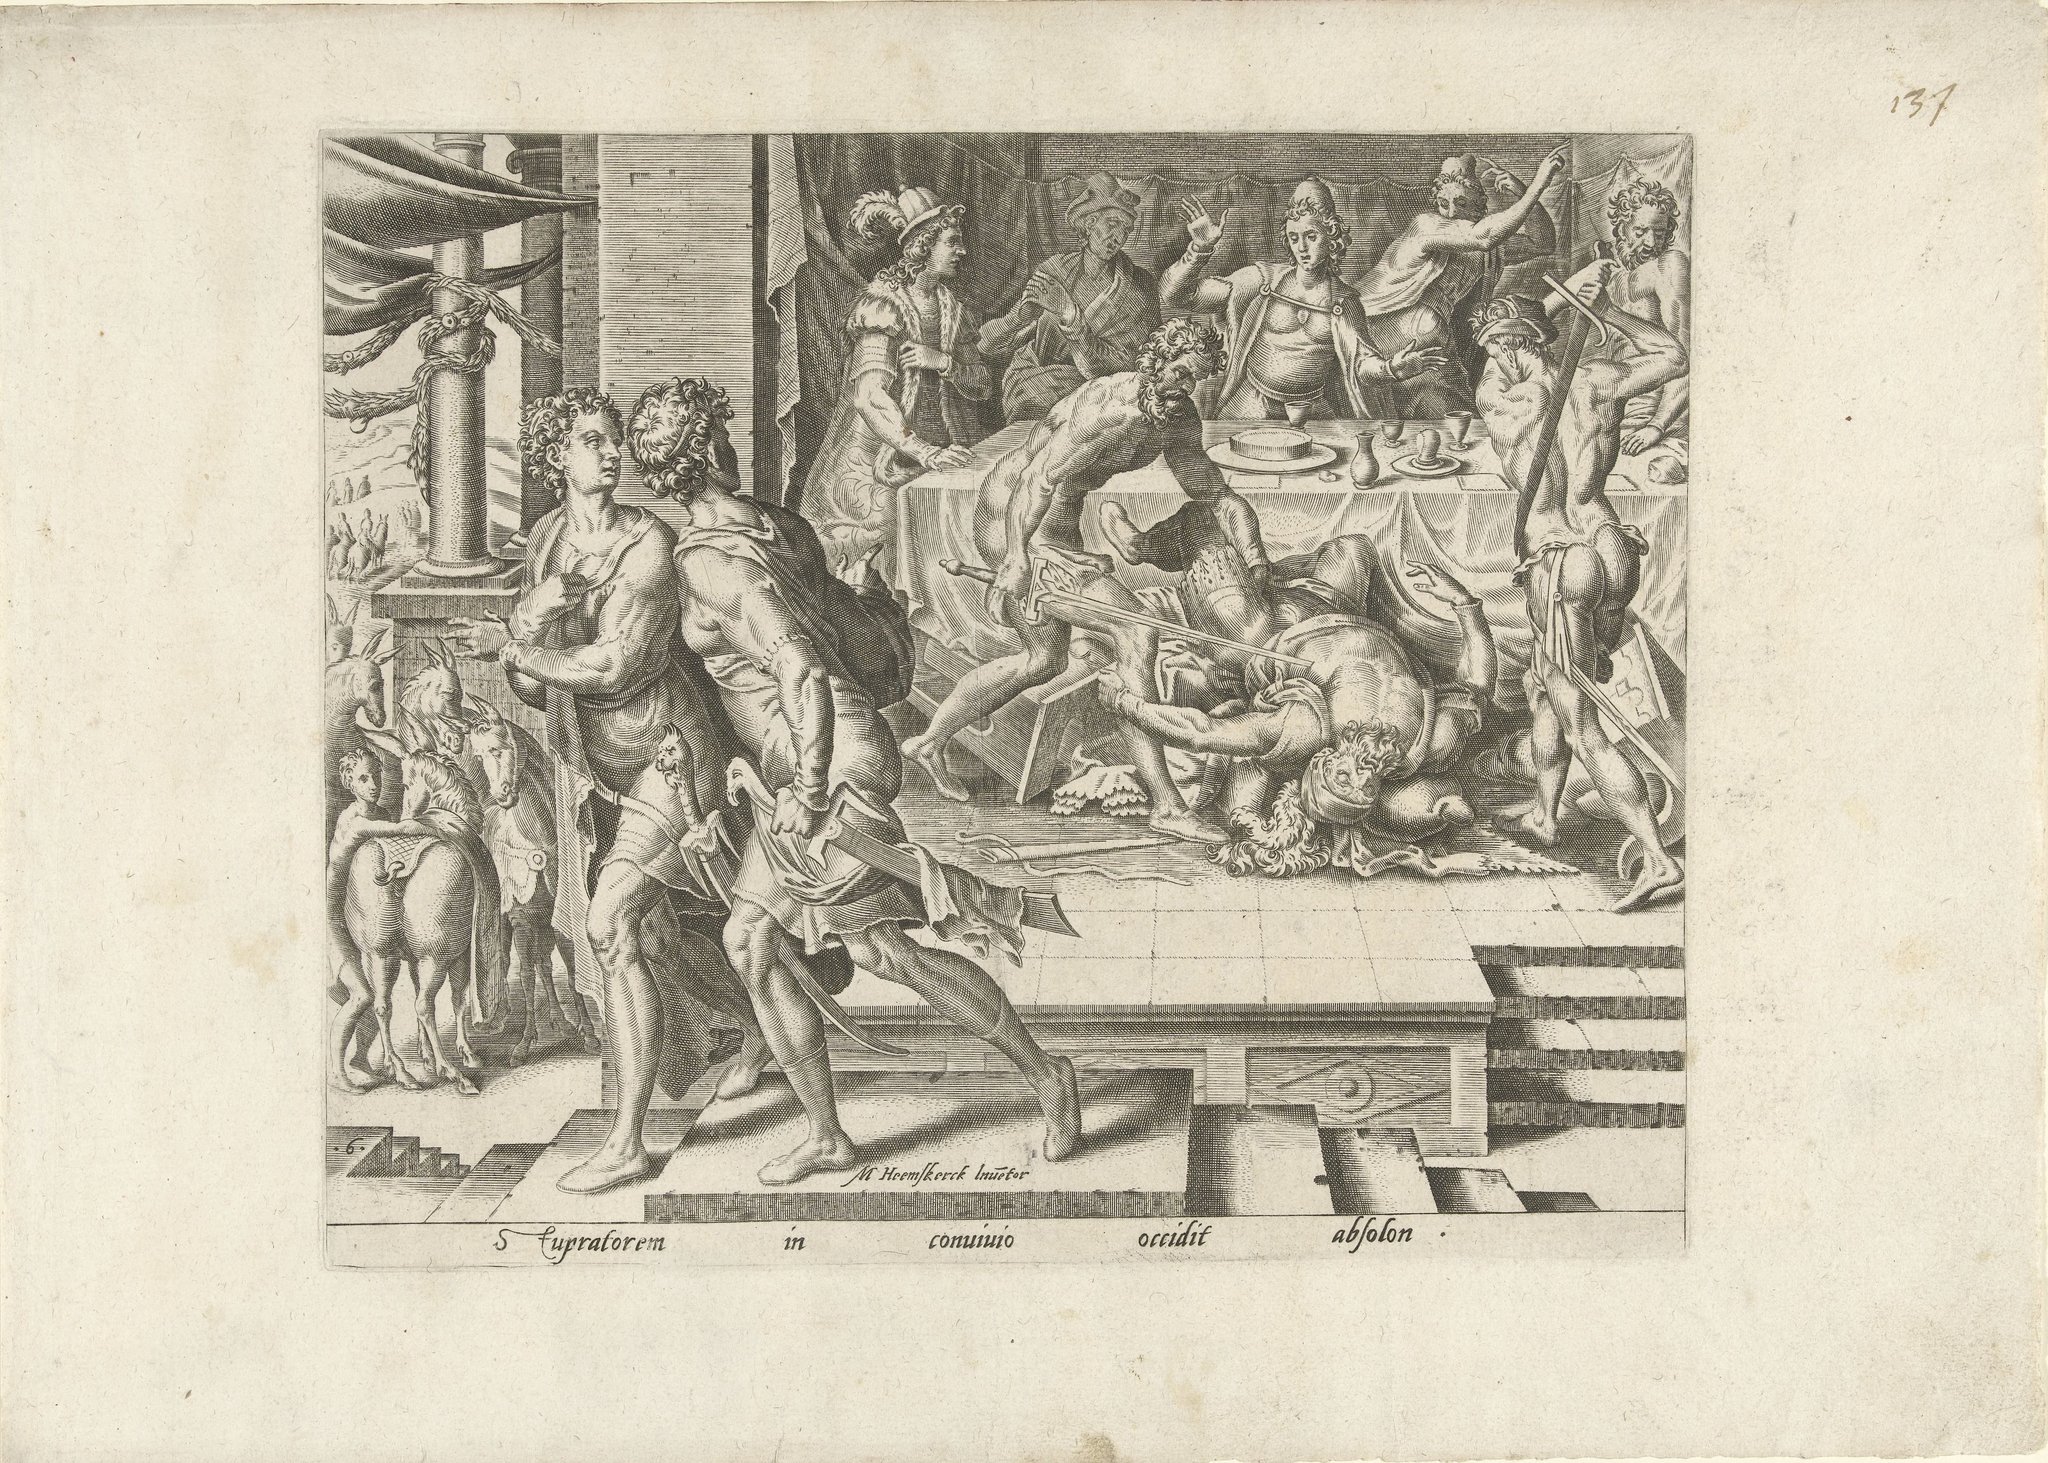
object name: print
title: Absaloms wraak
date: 1559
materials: paper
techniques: engraving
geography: antwerp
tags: amnon is murdered at absalom's banquet, the princes flee from absalom's banquet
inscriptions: collector's mark: Lugt 2228, collector's mark: Lugt 2760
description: Bij een diner voor de koningszonen laat Absalom zijn halfbroer Amnon vermoorden door zijn soldaten. Twee mannen vallen Amnon met zwaarden aan. Amnon ligt op de grond. De andere aanwezigen springen van hun stoelen en proberen te vluchten.